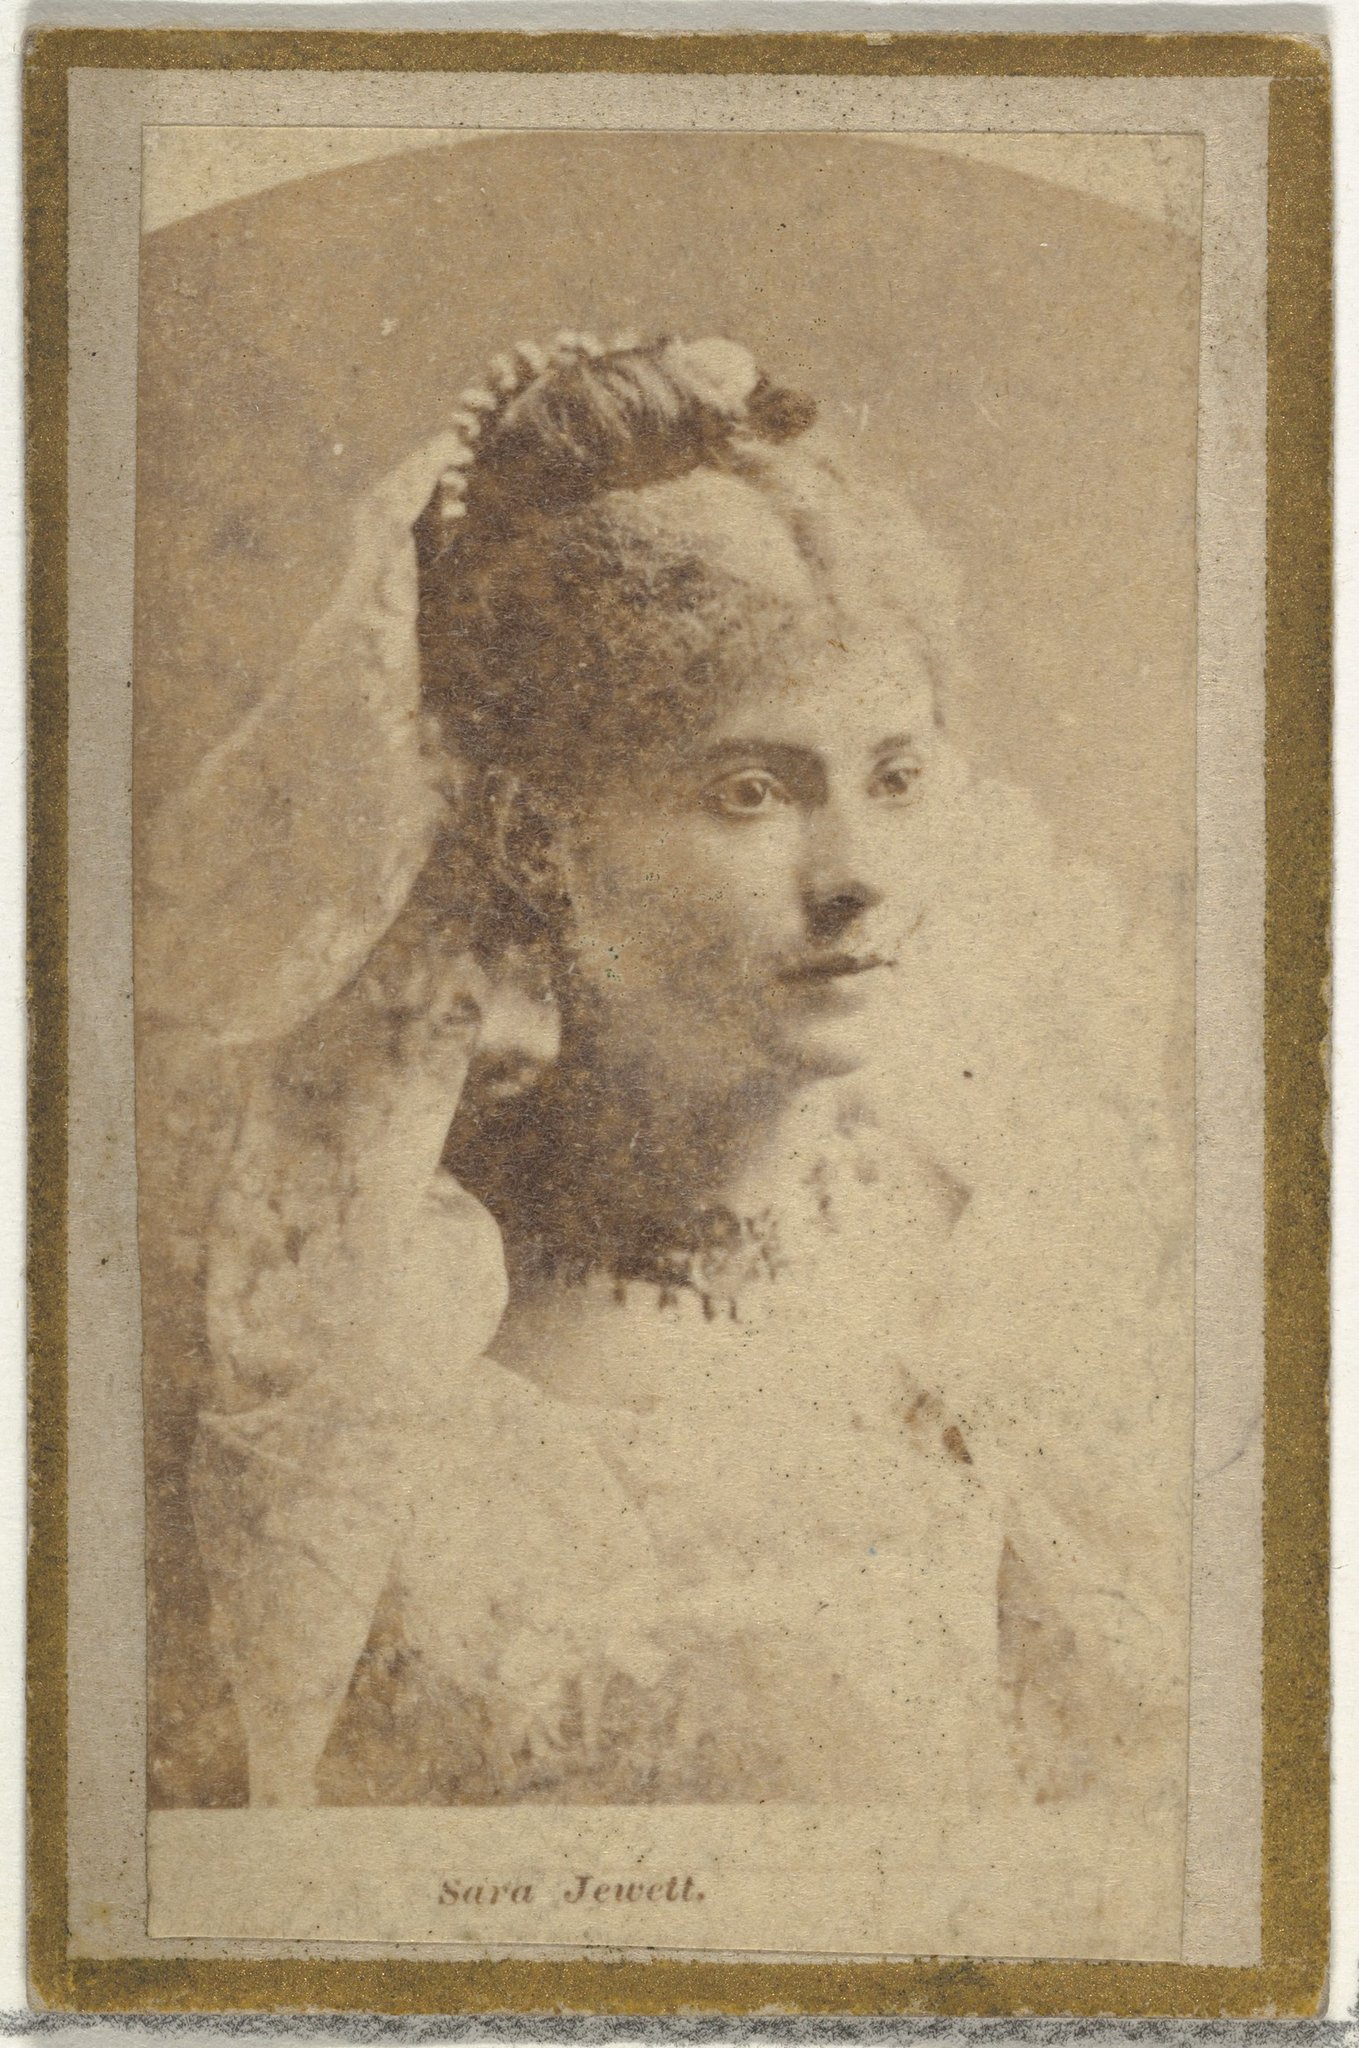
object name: photograph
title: Sara Jewett, from the Actresses and Celebrities series (N60, Type 2) promoting Little Beauties Cigarettes for Allen & Ginter brand tobacco products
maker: allen & ginter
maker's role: publisher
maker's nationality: american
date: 1887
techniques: albumen silver print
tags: portraits,women,actresses